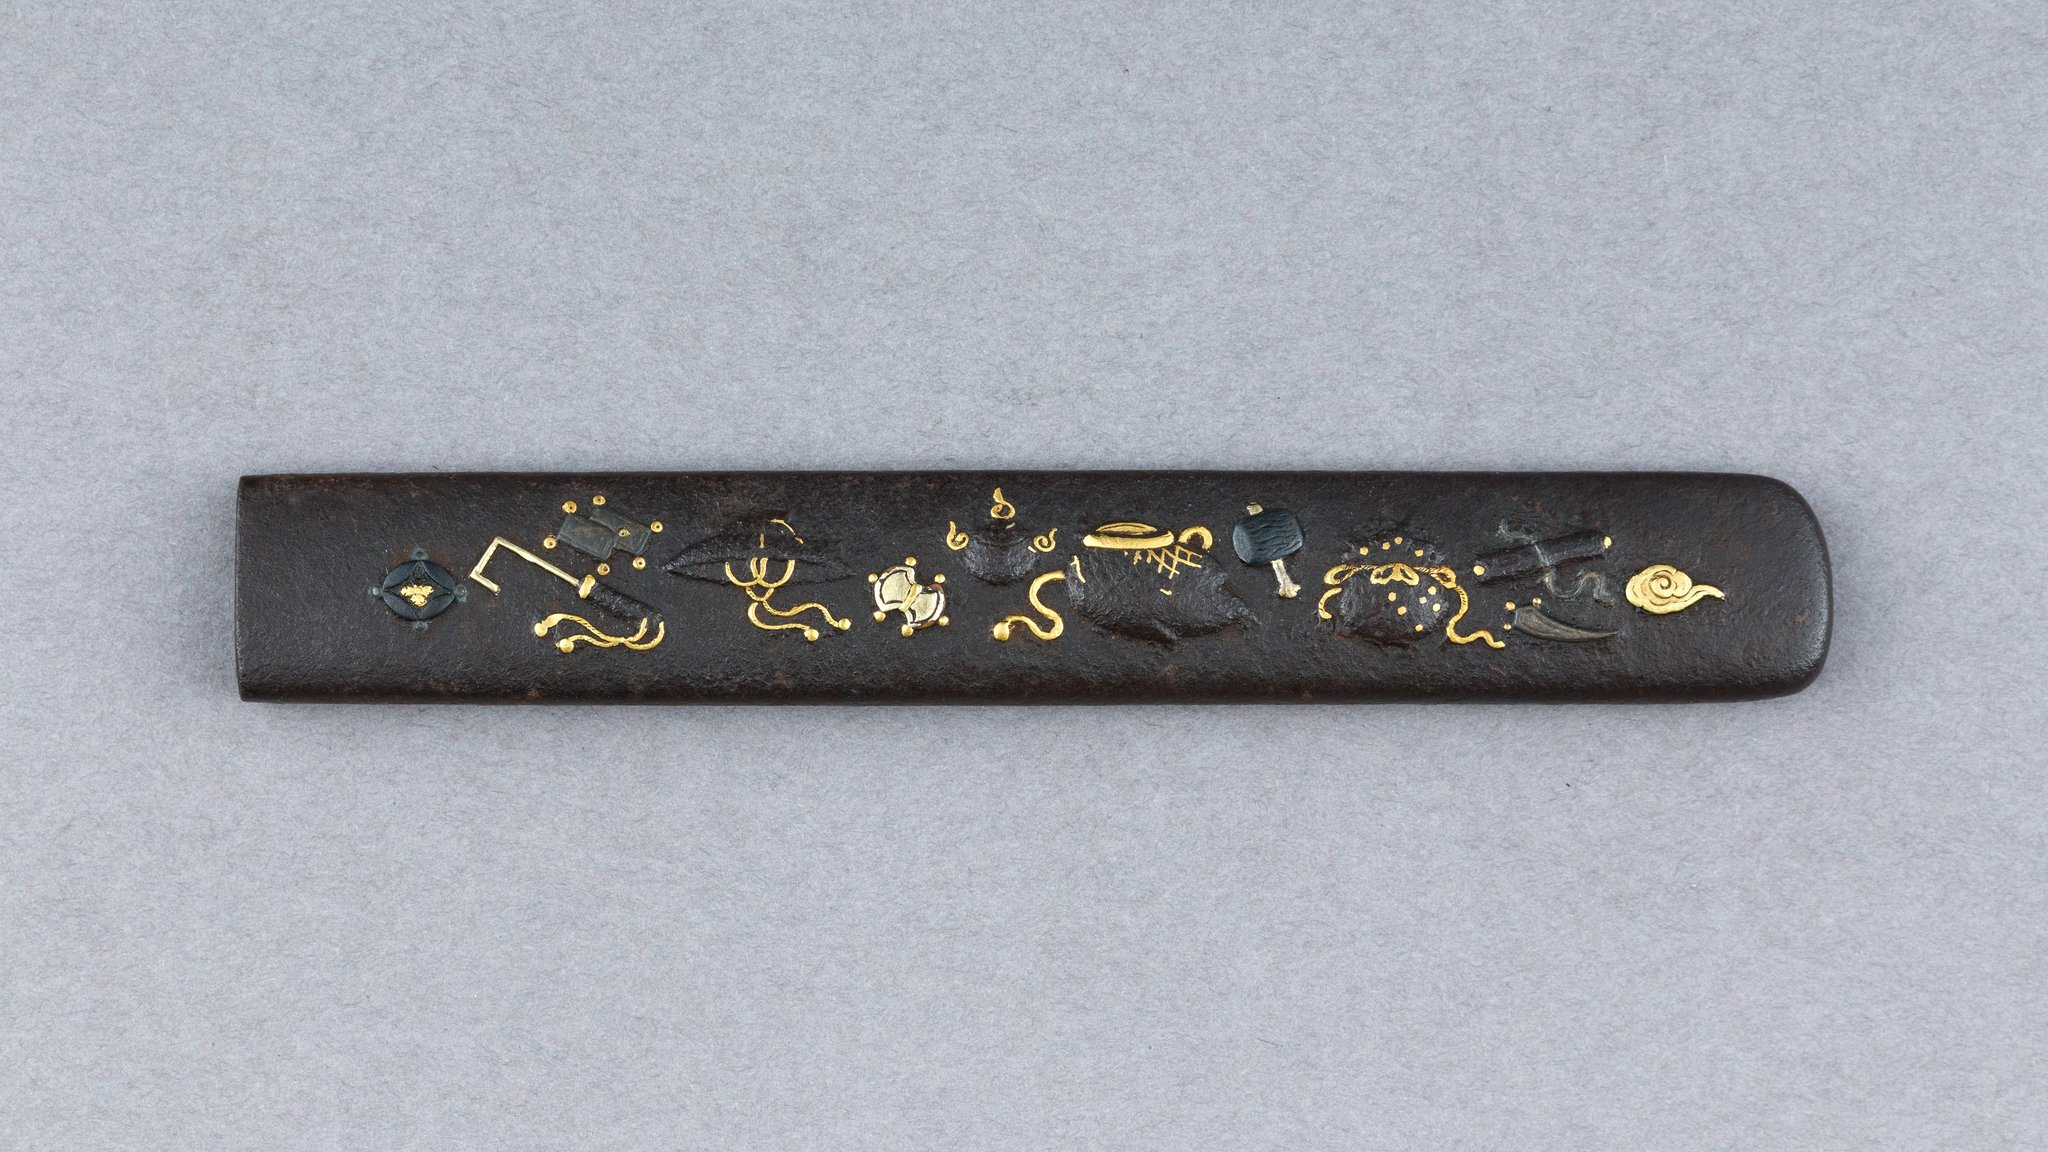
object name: knife handle kozuka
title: Knife Handle (Kozuka)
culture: japanese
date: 1615-1868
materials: gold, iron, silver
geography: japan